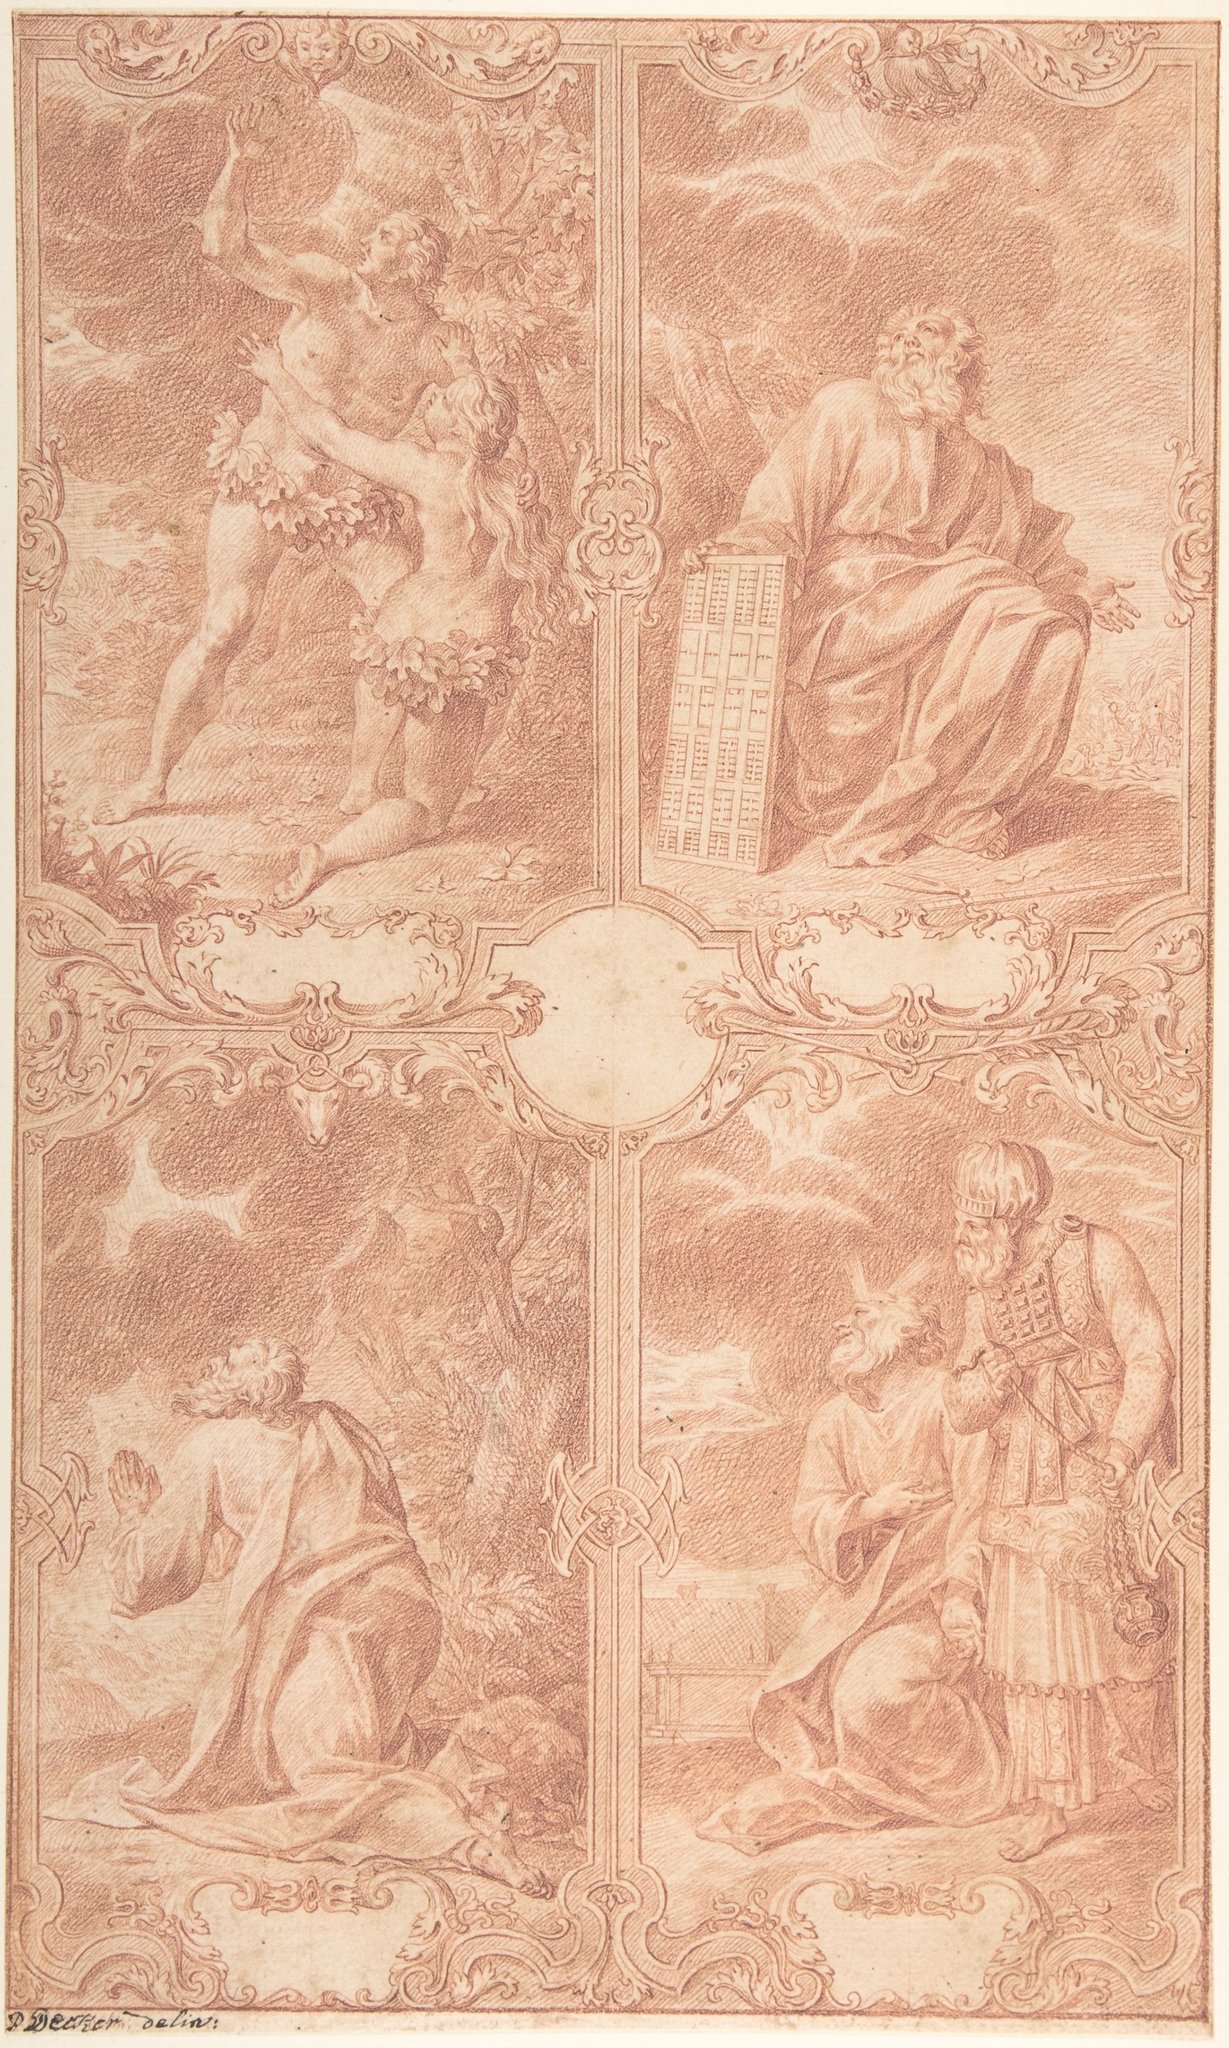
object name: drawing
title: Four Scenes from the Old Testament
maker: paul decker the younger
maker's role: artist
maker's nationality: german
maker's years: 1685-1742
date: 1701-1733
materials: chalk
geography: germany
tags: human figures